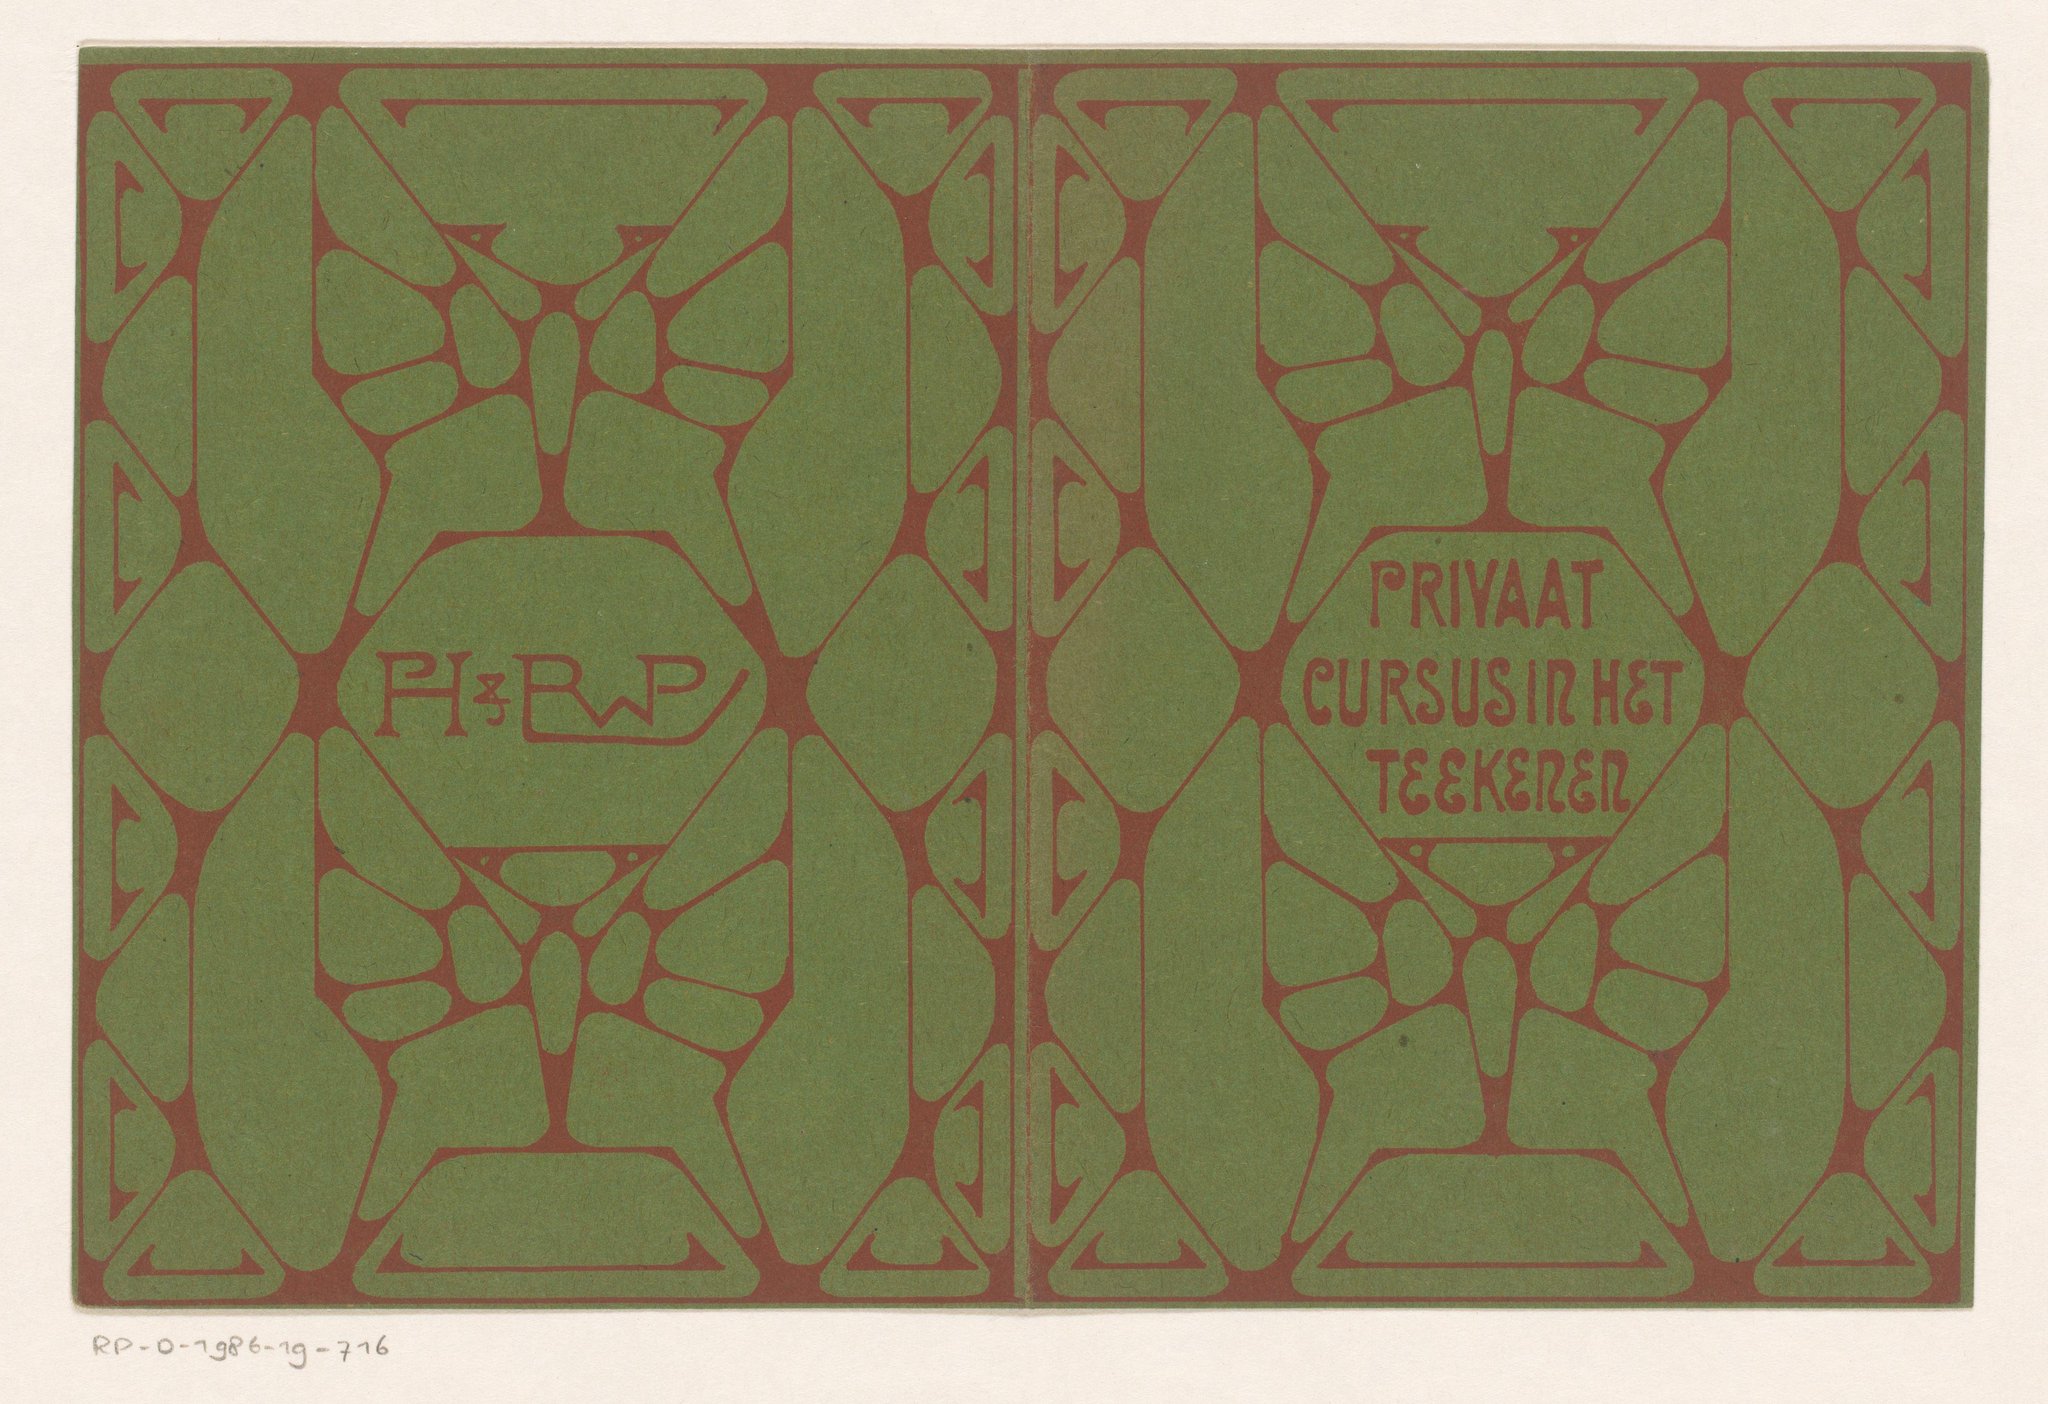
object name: print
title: Reclamekaart voor een privaat-cursus in het tekenen door R.W.P. de Vries Jr.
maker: Anonymous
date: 1884-1952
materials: paper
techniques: lithograph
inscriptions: collector's mark: ‘R:MVS.’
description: Omslag met decoratief patroon met in twee kaders de naam van de cursus en de initialen van de docenten (R.W.P. de Vries Jr. en Paul Hermann).